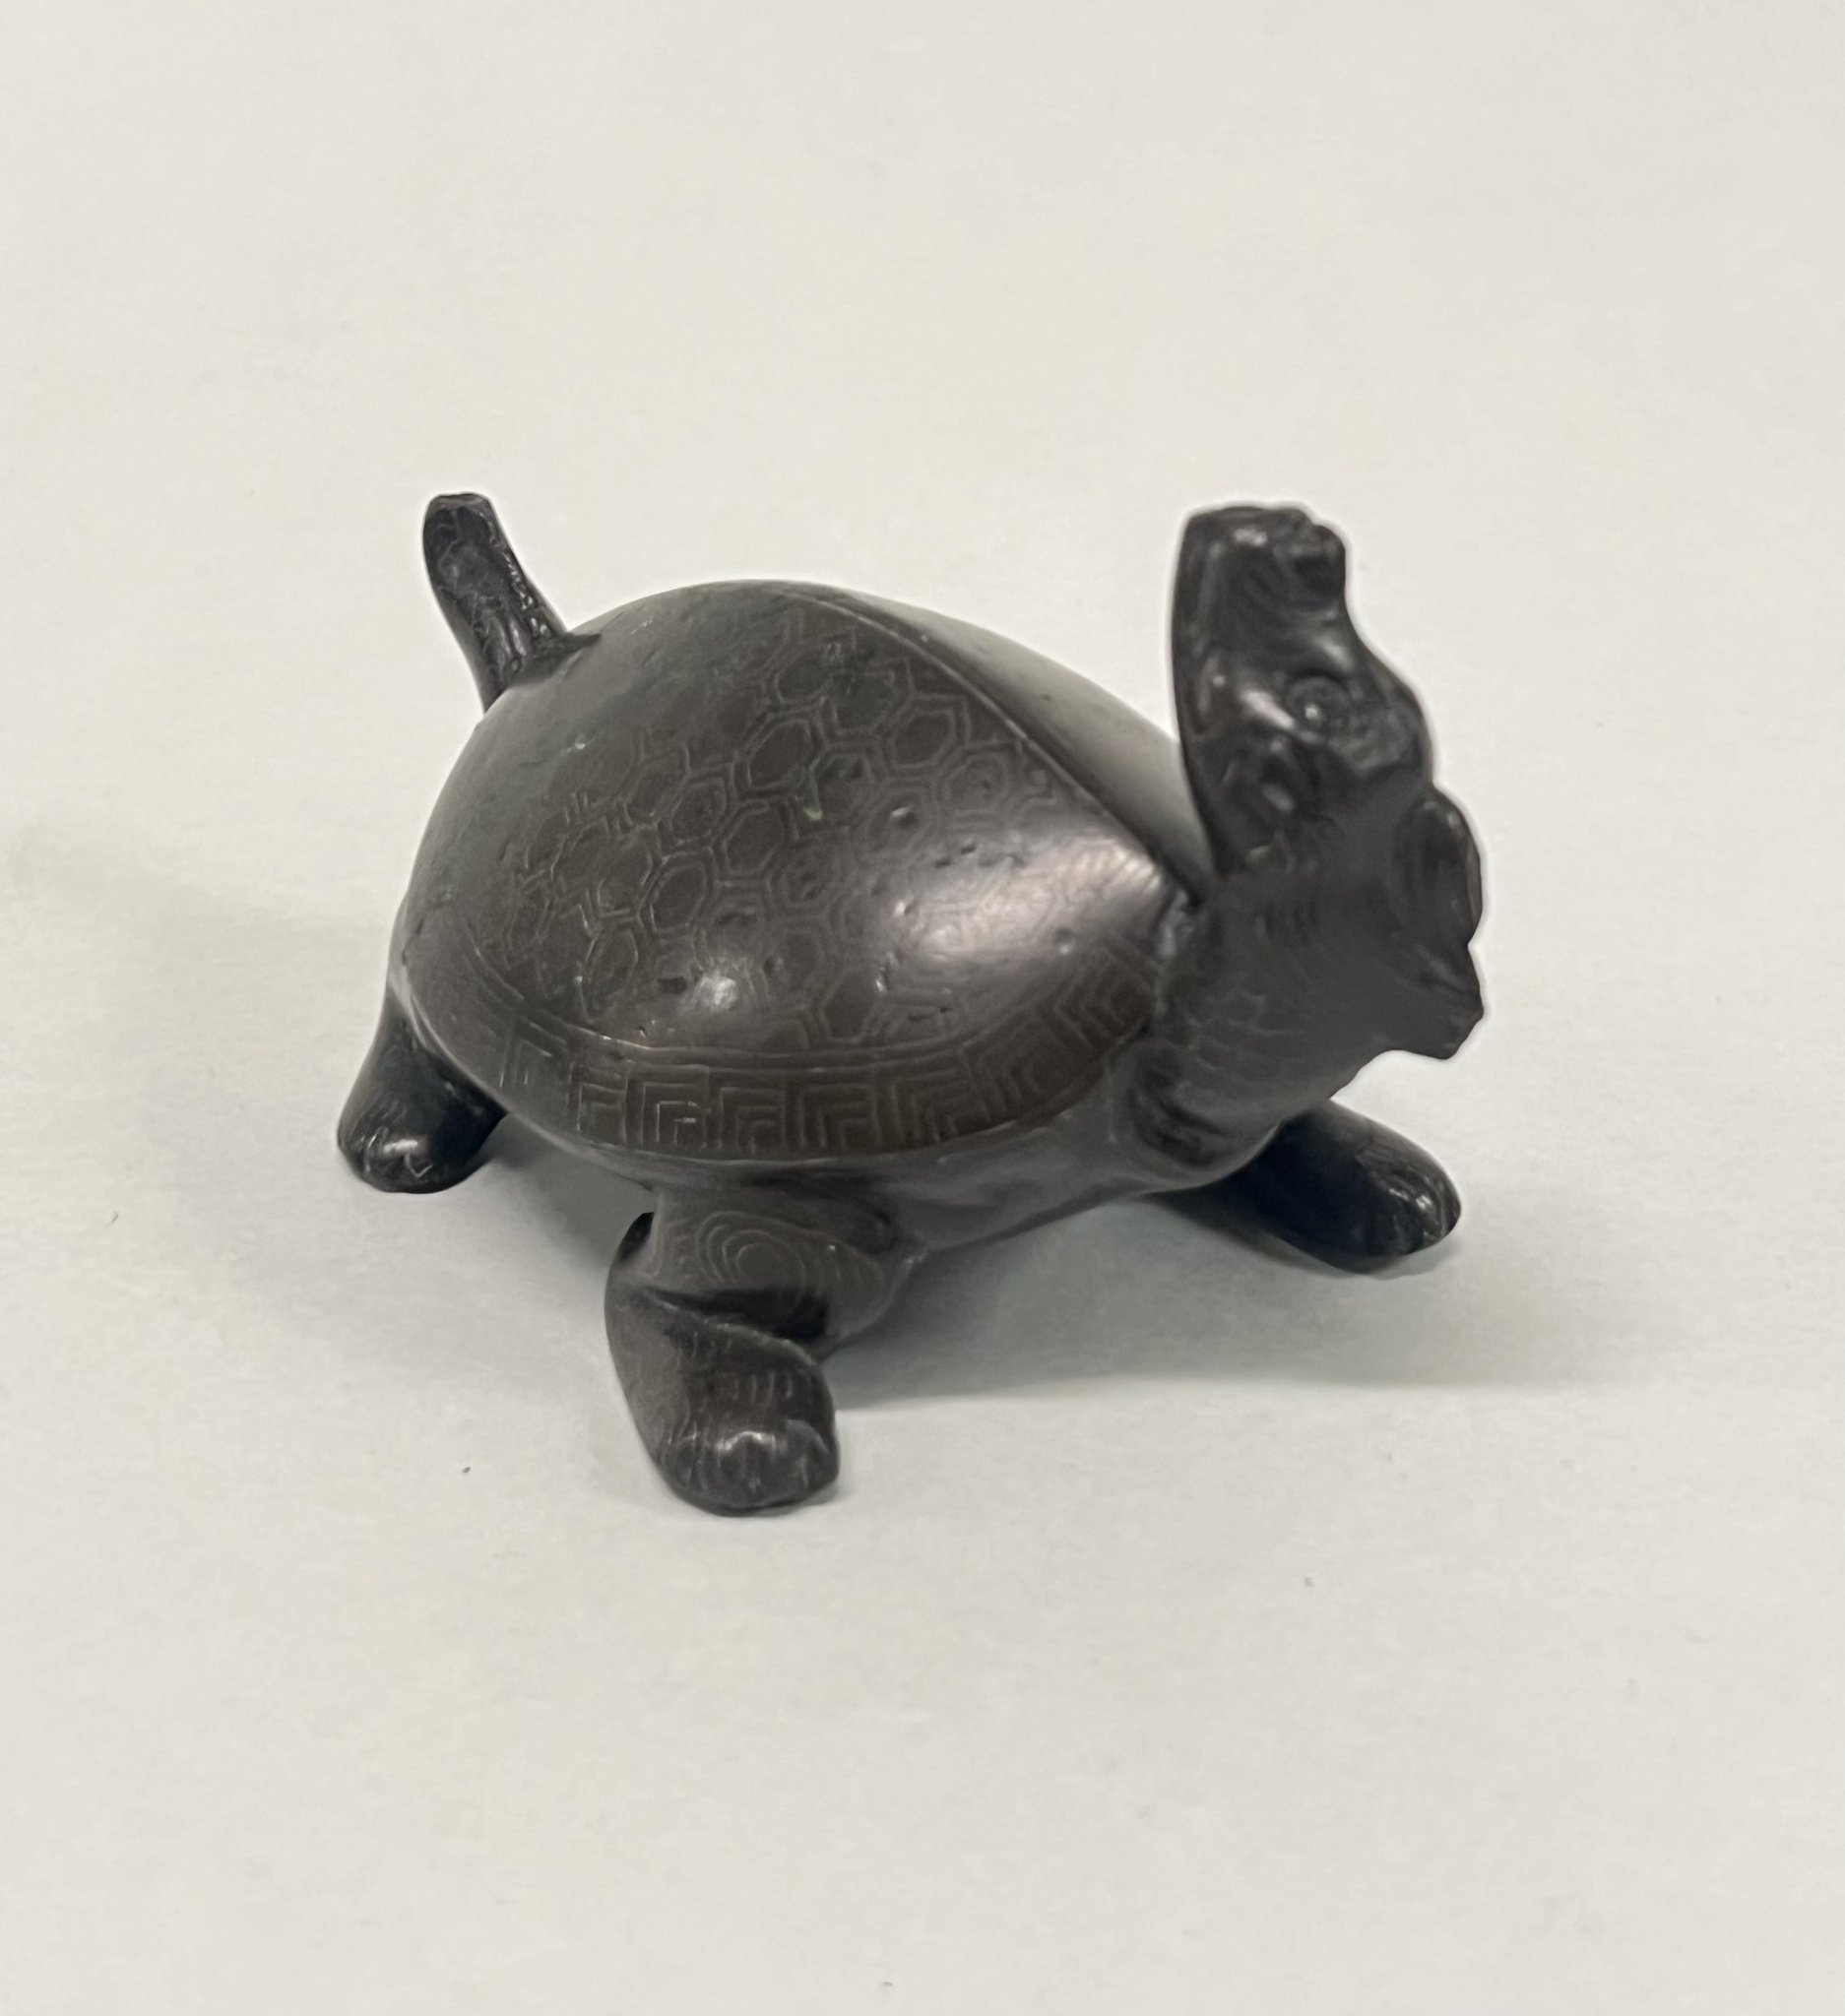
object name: figure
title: Figure of a Turtle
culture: japanese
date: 1701-1900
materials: bronze